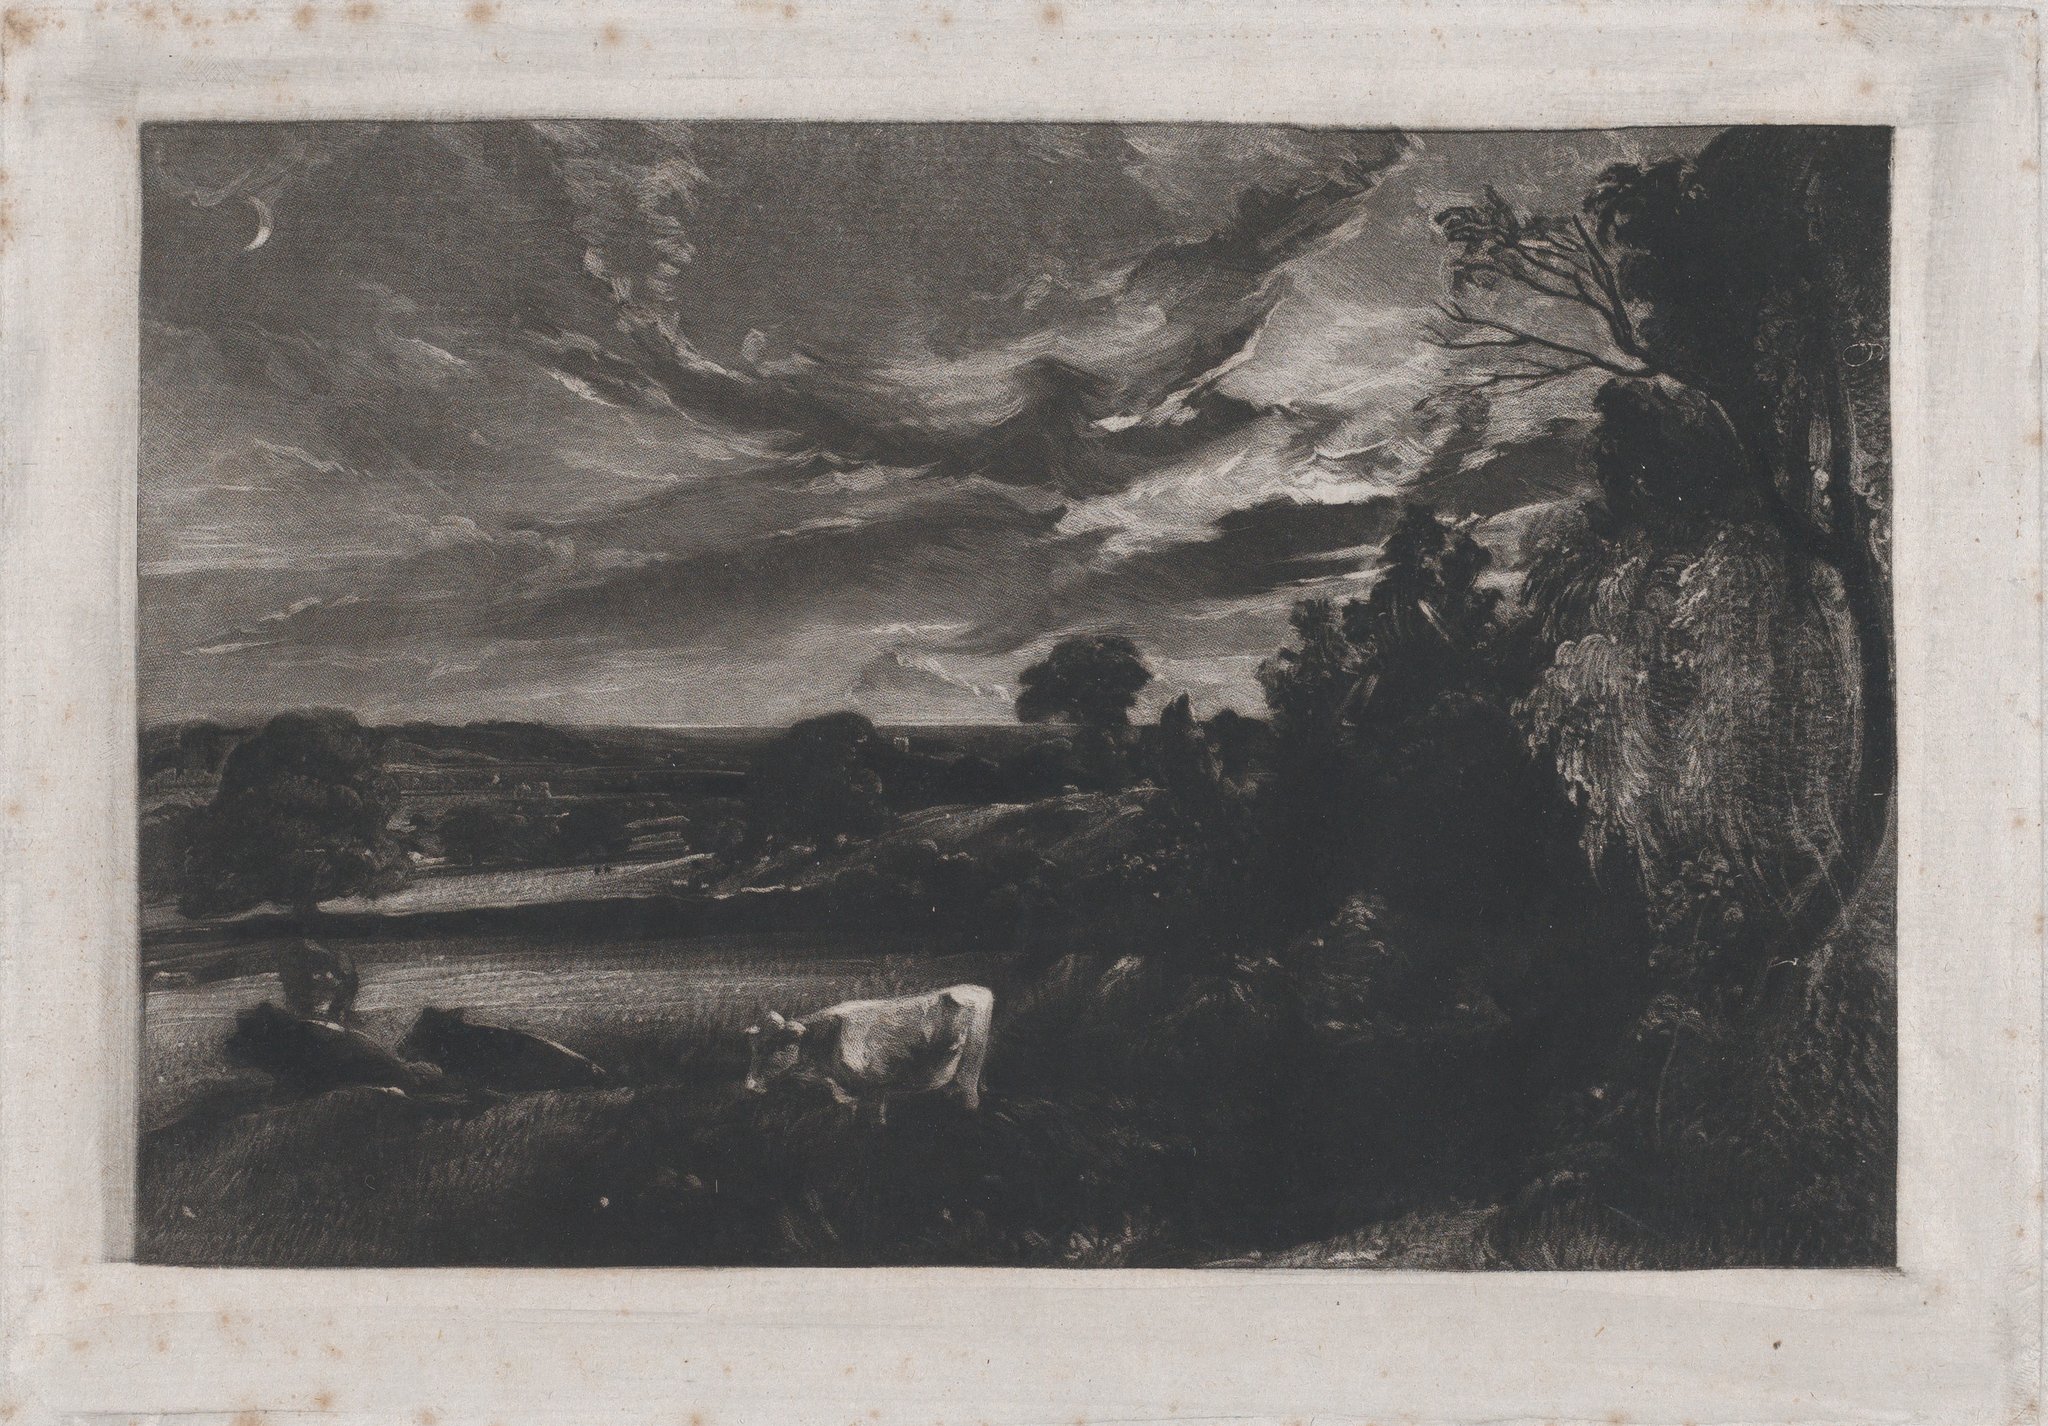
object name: print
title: Summer Evening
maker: david lucas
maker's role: artist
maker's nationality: british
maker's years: 1802-1881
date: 1829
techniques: mezzotint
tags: cows,landscapes,evening